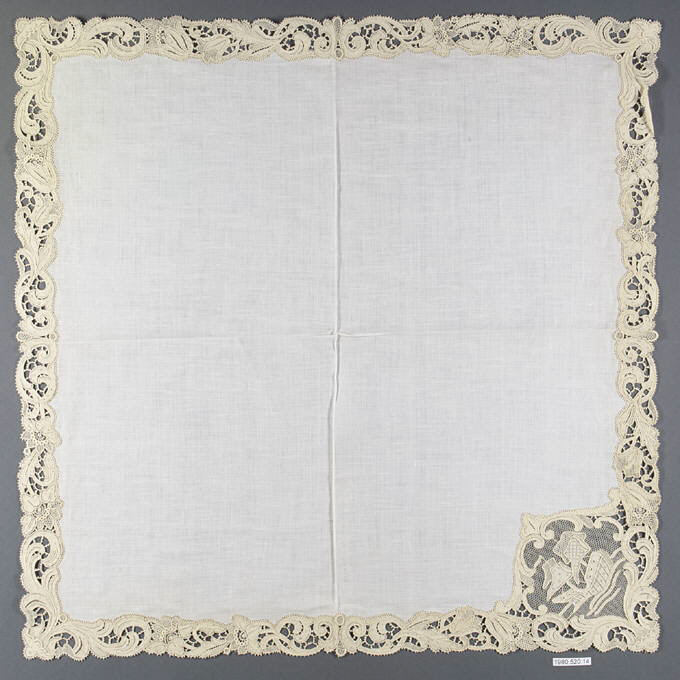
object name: napkin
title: Napkin (from a set of table linens)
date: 1867-1900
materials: linen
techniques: lace